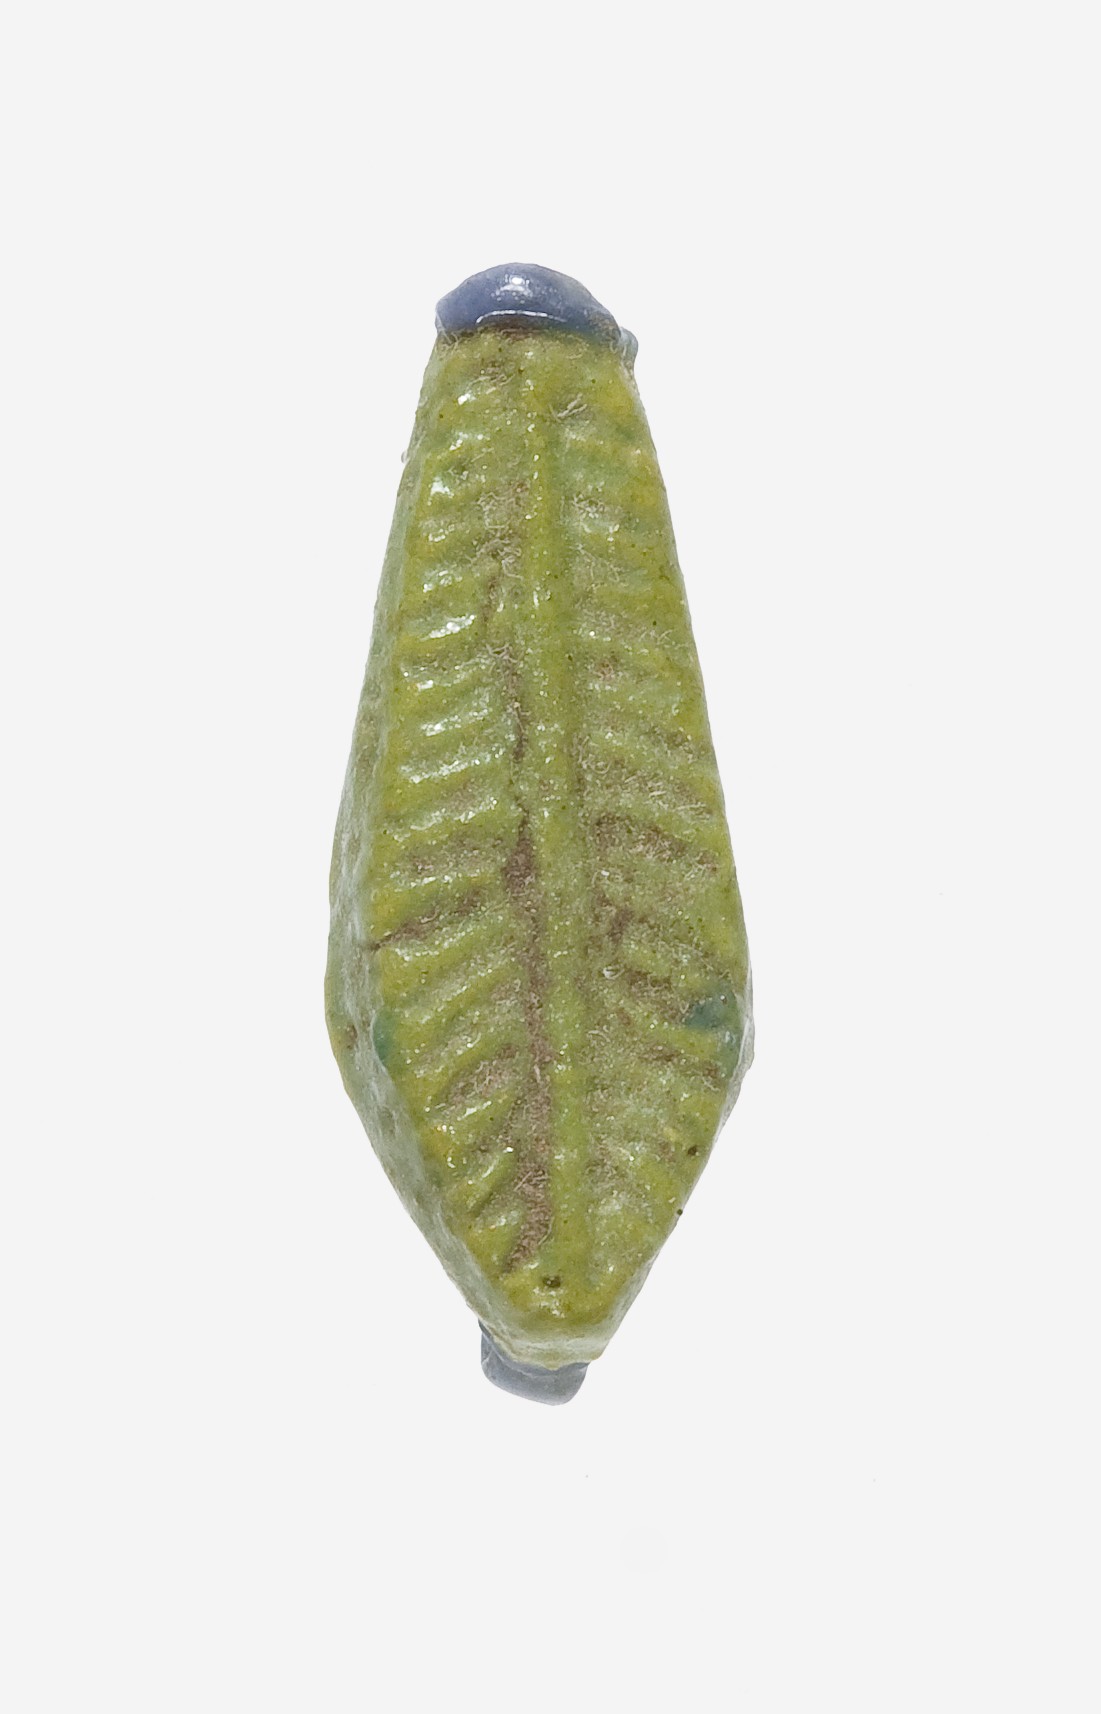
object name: pendant, leaf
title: Leaf Pendant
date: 1390-1352 BCE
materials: faience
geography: egypt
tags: leaves